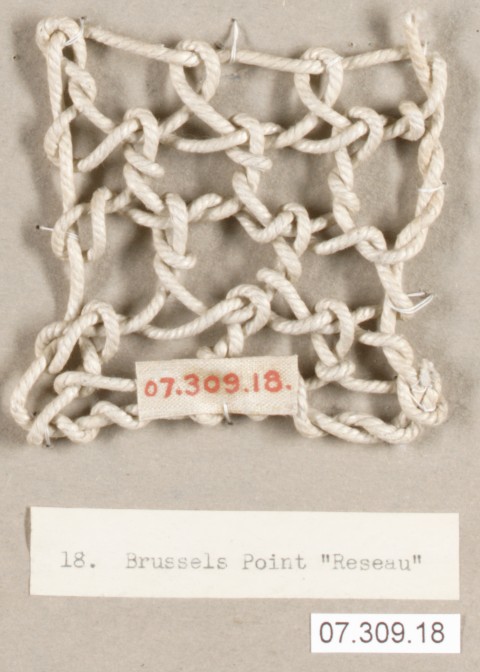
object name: stitch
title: Example of lace stitch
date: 1801-2000